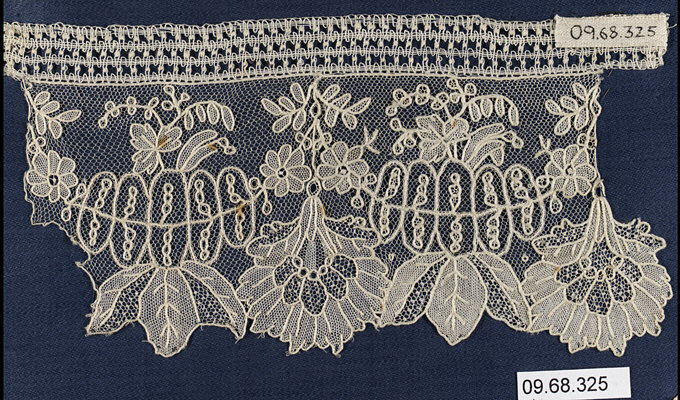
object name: fragment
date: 1801-1900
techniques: lace